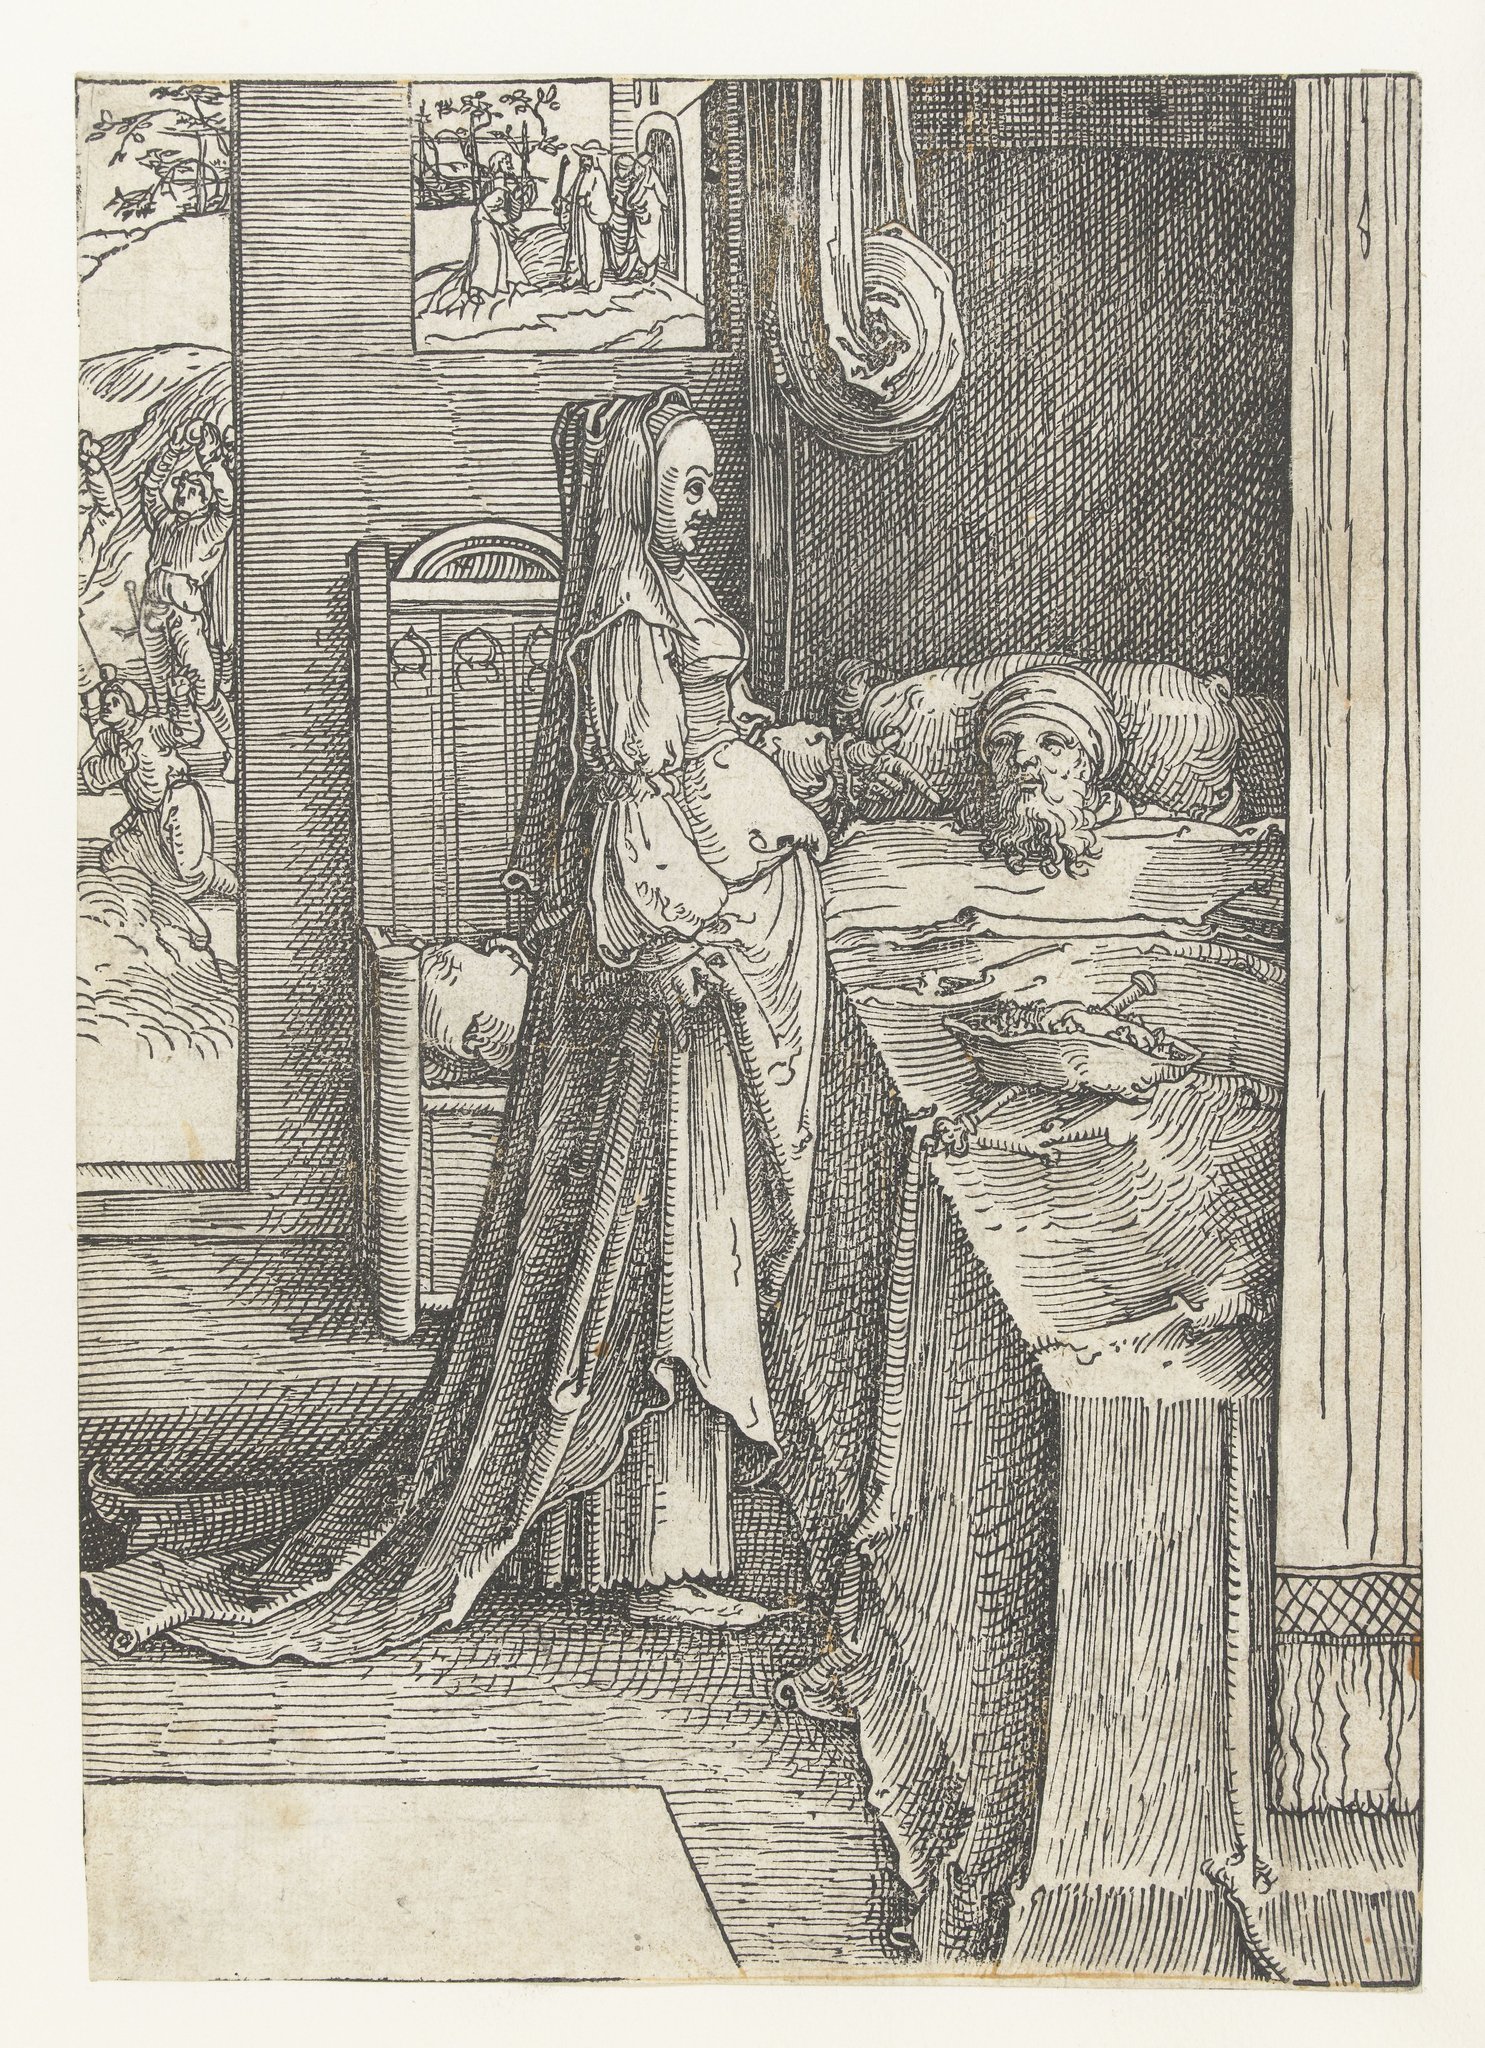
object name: print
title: Kleine serie Vrouwenlisten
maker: lucas van leyden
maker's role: draughtsman, painter, print maker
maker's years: 1494-1533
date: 1515-1519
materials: paper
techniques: pen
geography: low countries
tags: naboth is stoned to death, jezebel comforts ahab, naboth refuses to sell his vineyard to ahab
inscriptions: collector's mark: Lugt 2228a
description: Drie scènes uit het verhaal van Izebel. Achab liggend in bed, zijn vrouw Izebel staand bij bed probeert hem op te beuren. Door raam is Naboth te zien die Achab wijngaar weigert, door deuropening is de steniging van Naboth te zien.